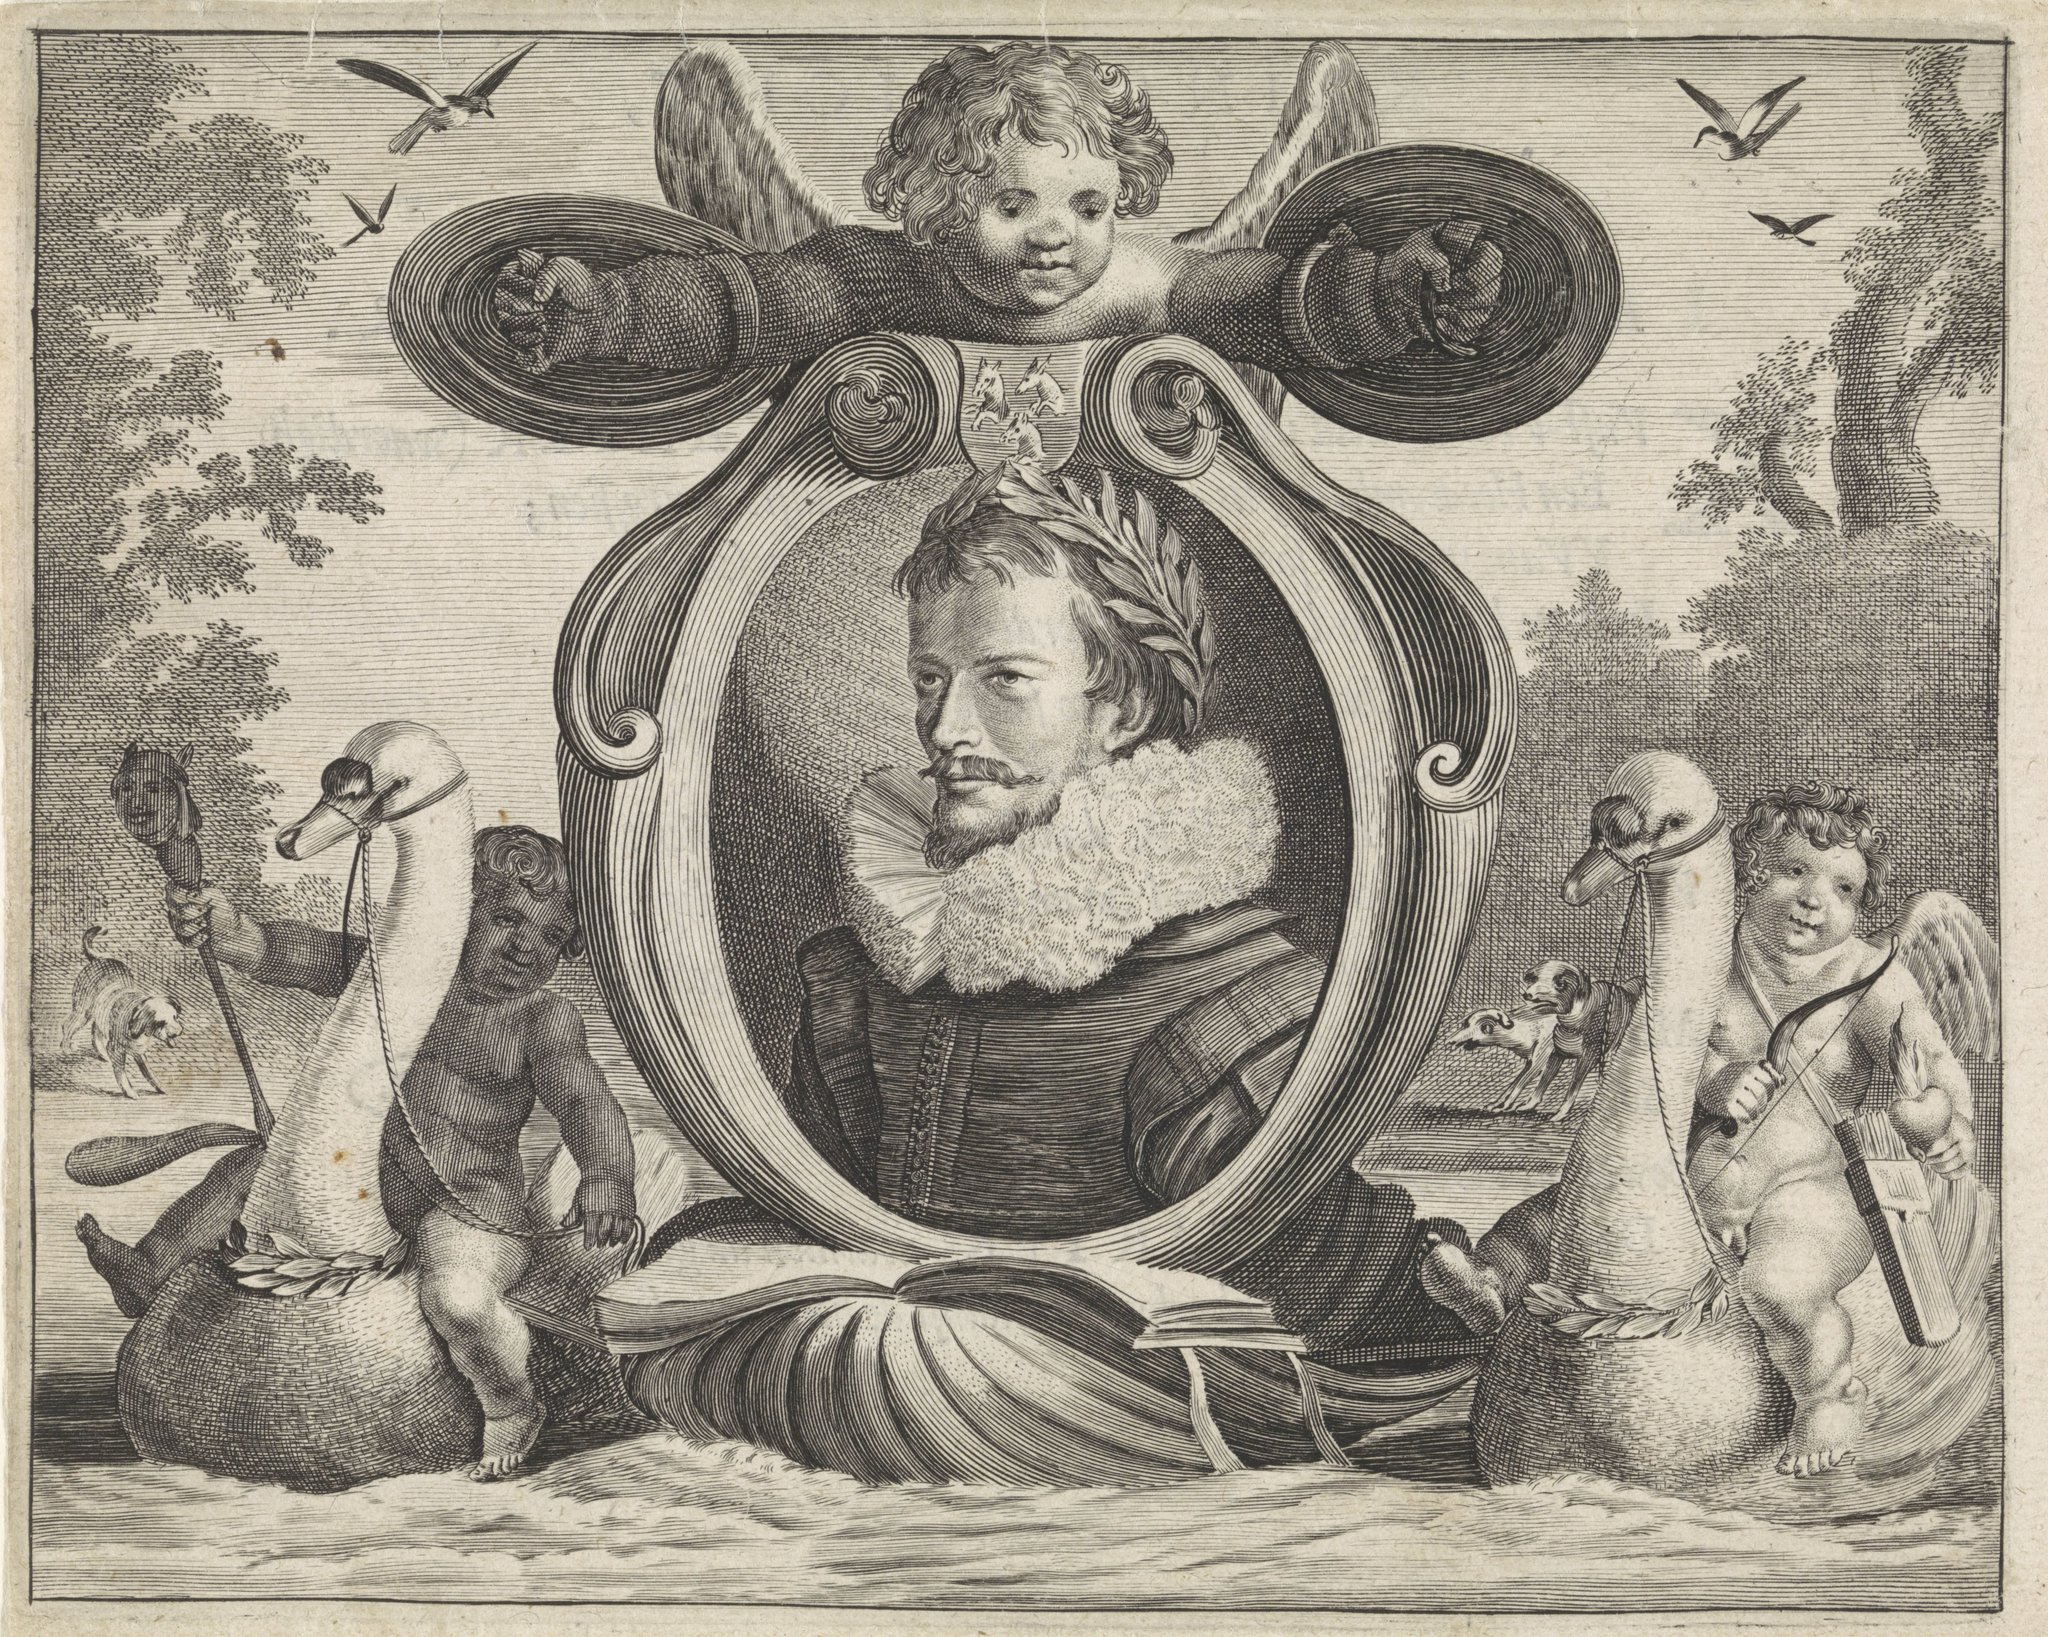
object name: print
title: Portret van Jan Jansz Starter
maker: jan van de velde (ii)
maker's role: draughtsman, painter, print maker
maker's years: 1593-1641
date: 1623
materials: paper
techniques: engraving, letterpress printing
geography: northern netherlands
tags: london, publisher, jan jansz starter, portrait of a writer, cupids: 'amores', 'amoretti', 'putti', water-birds: swan (+ animals used symbolically)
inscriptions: collector's mark: Lugt 964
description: Prent gebruikt in: Starter, Jan Jansz. Friesche lust-hof, beplant met verscheyde stichtelĳcke minne-liedekens, gedichten, ende boertige kluchten. Tweede editie. Amsterdam: weduwe Dirck Pietersz Voscuyl, 1623.